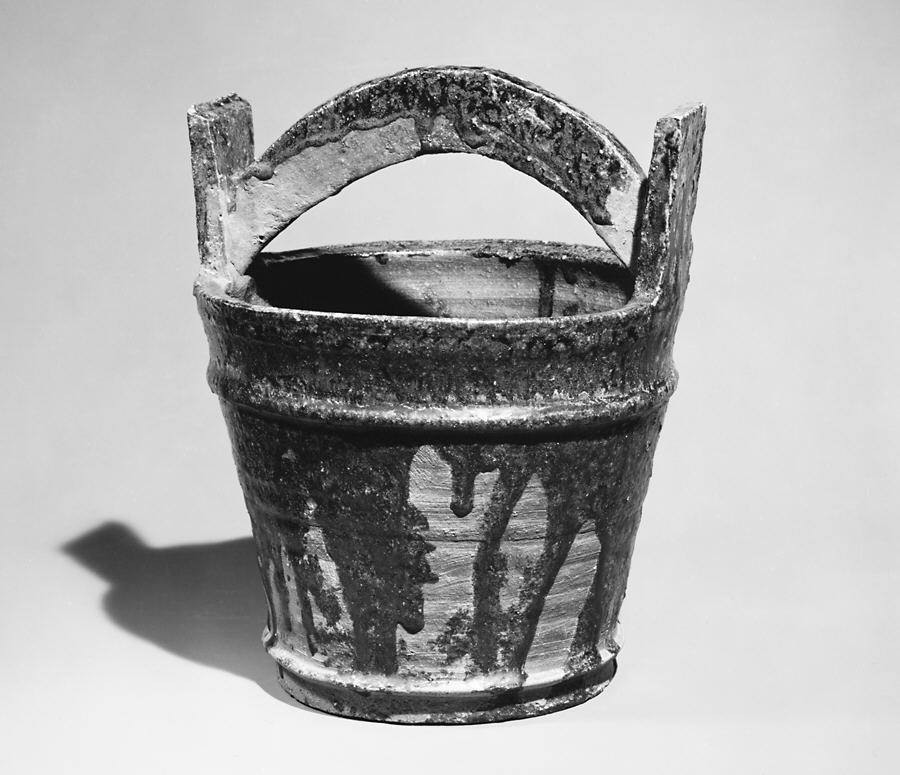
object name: pot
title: Water Pot for Tea Ceremony (Mizusashi)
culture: japanese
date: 1573-1615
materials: glaze, iron, stoneware